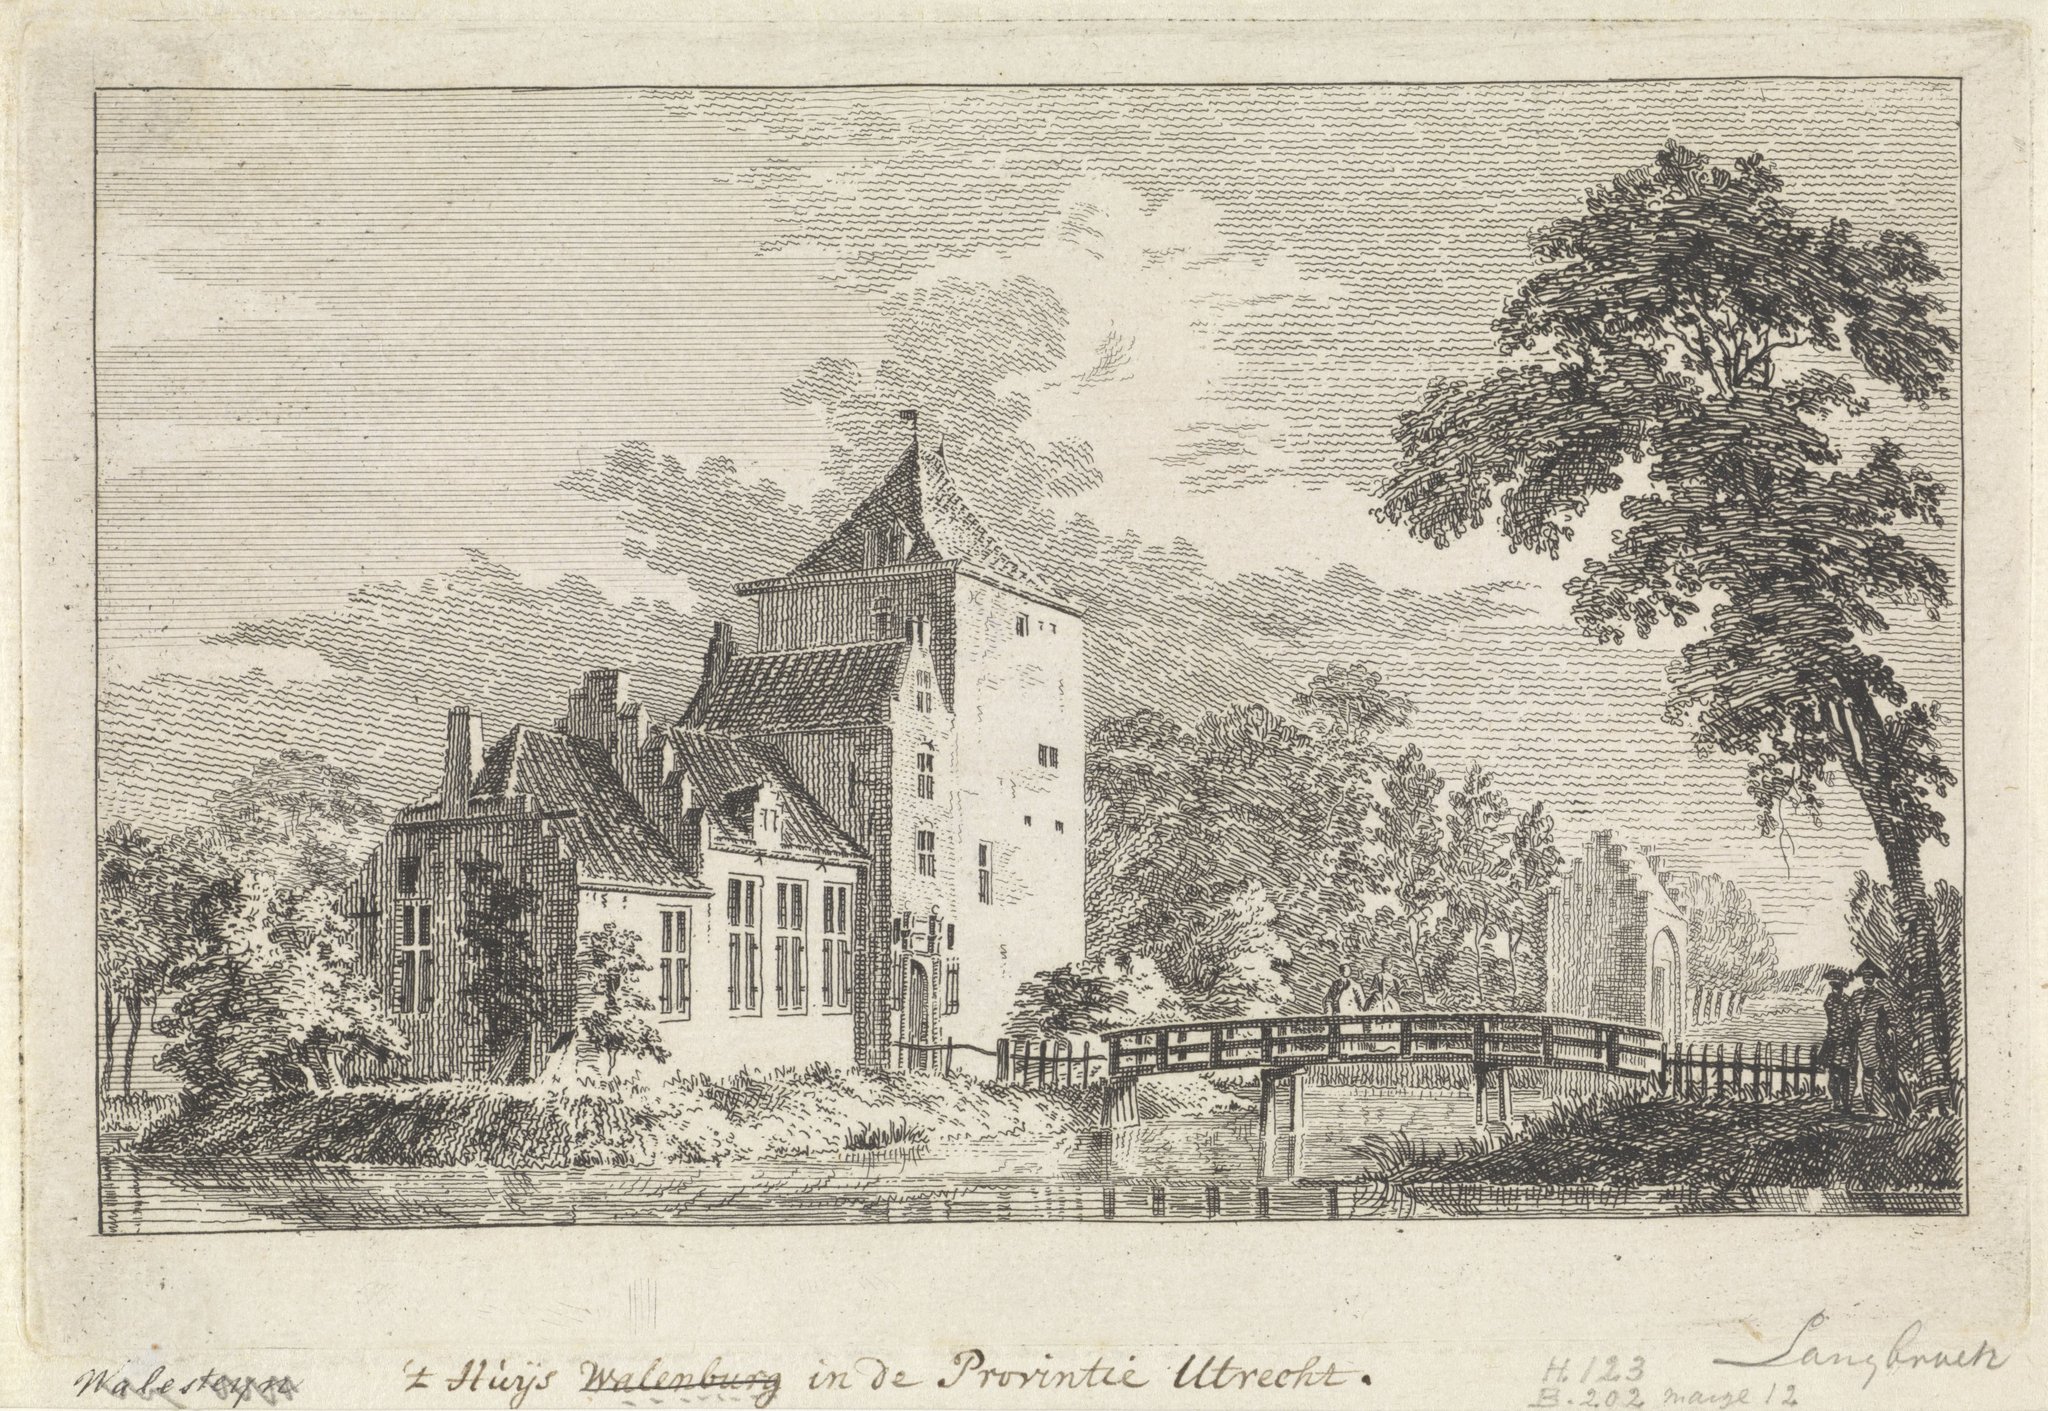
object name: print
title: Gezicht op kasteel Walenburg, Nederlangbroek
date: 1757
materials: paper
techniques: etching, pen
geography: haarlem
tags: castle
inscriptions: collector's mark: Lugt 2228, inscription: ‘'t Huijs Walenburg in de Provintie Utrecht’